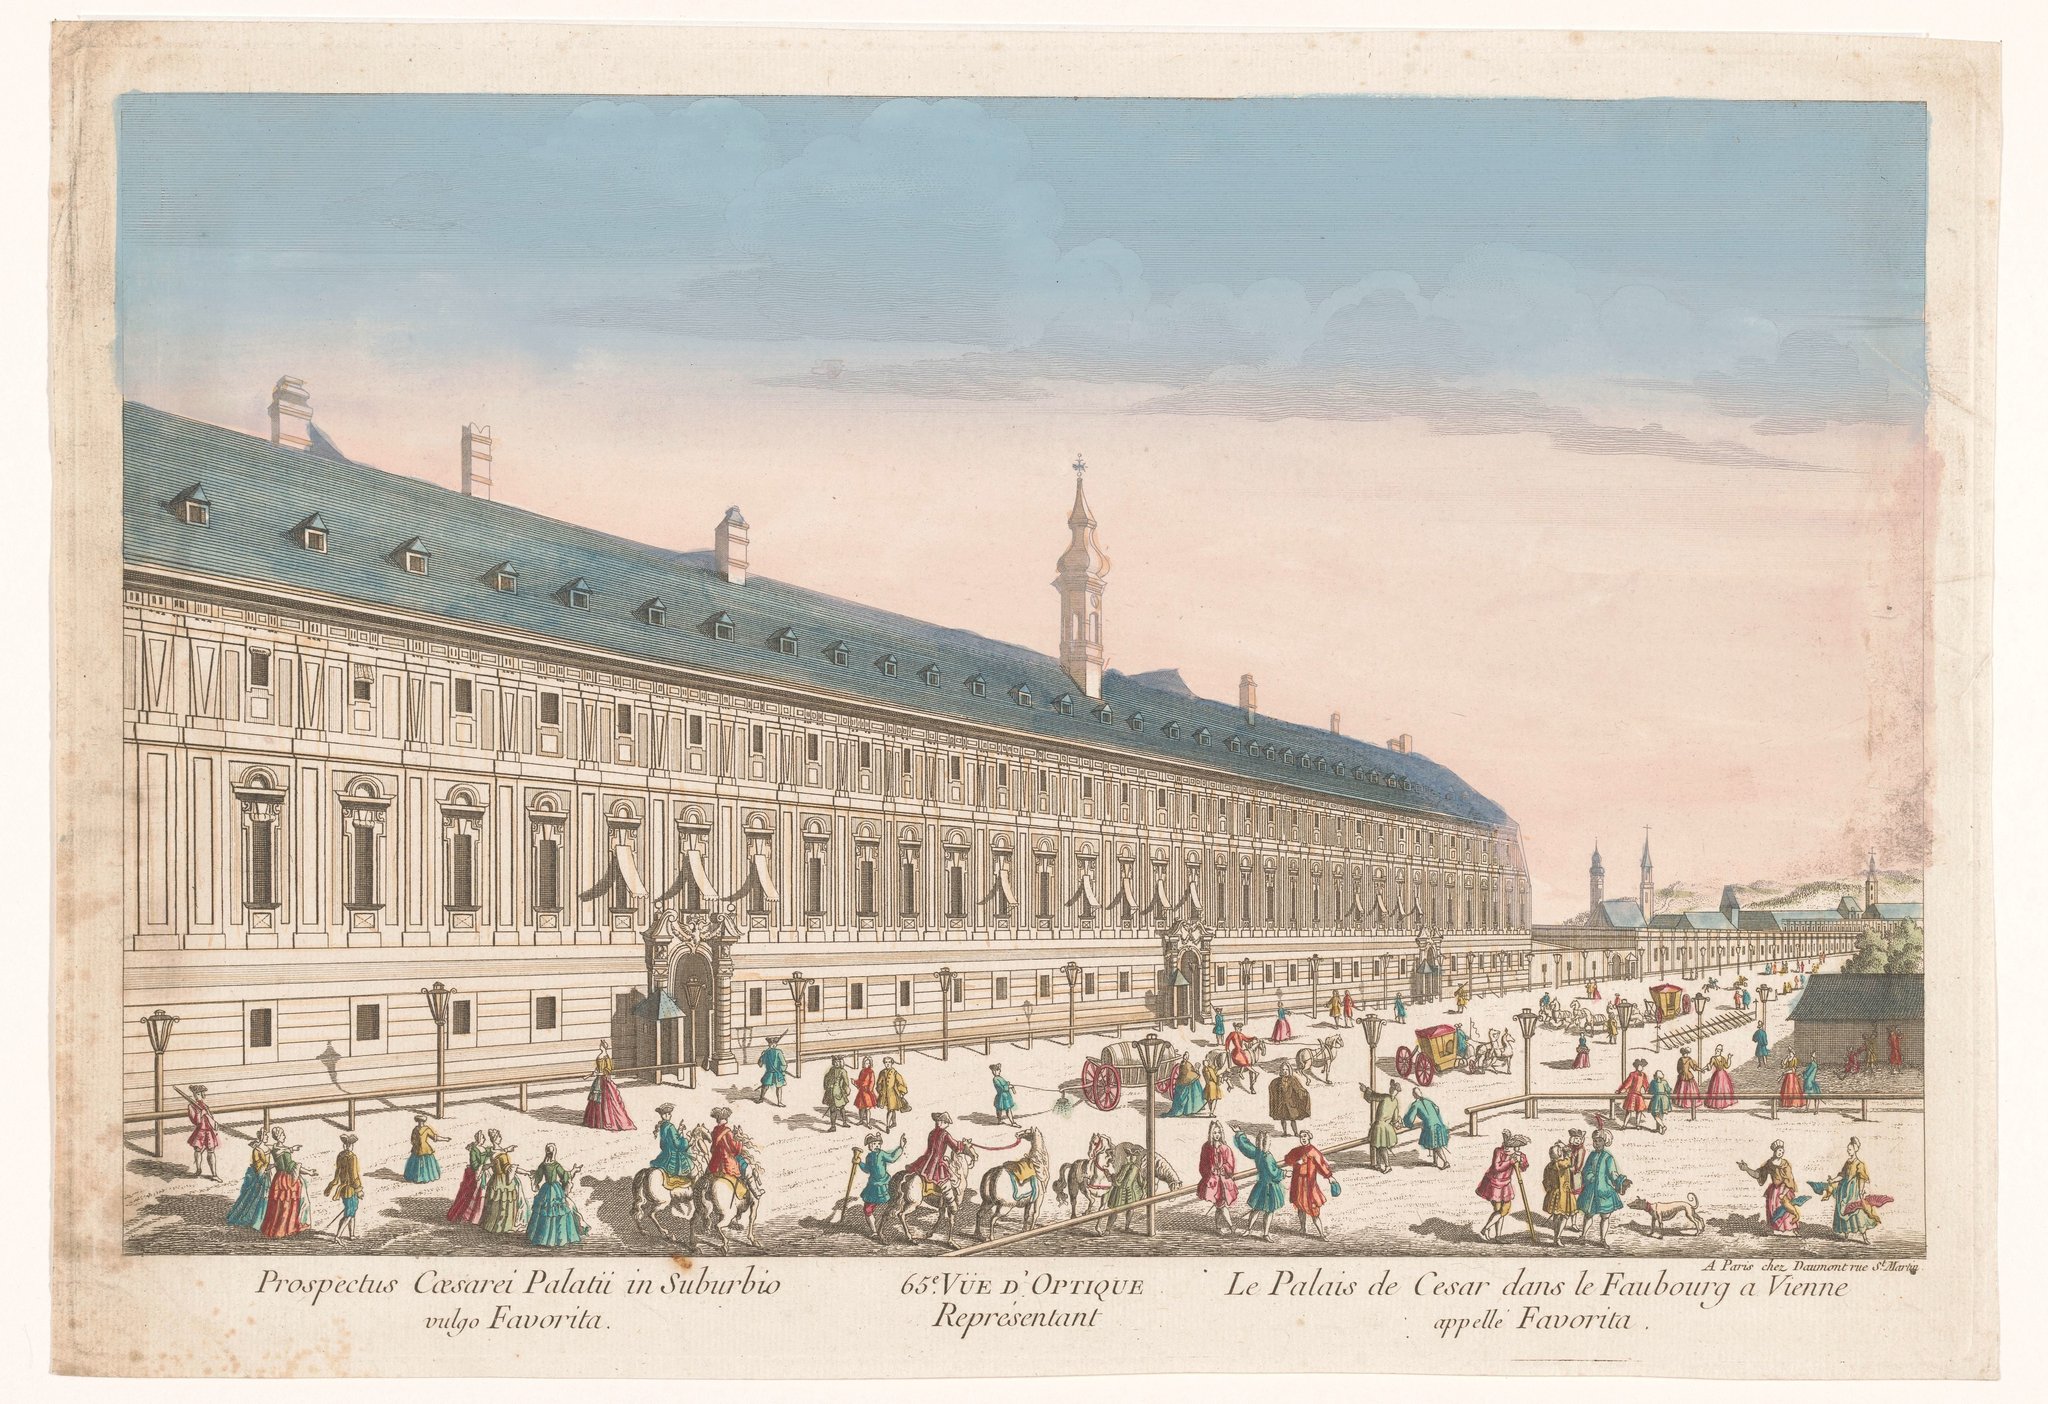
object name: opticaprent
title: 65e. Vüe d'optique représentant le palais de Cesar dans le faubourg a Vienne appelle Favorita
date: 1745-1775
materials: paper, watercolor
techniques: brush, etching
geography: france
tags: palace, street (+ city(-scape) with figures, staffage), vienna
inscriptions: watermark, collector's mark: Lugt 2233